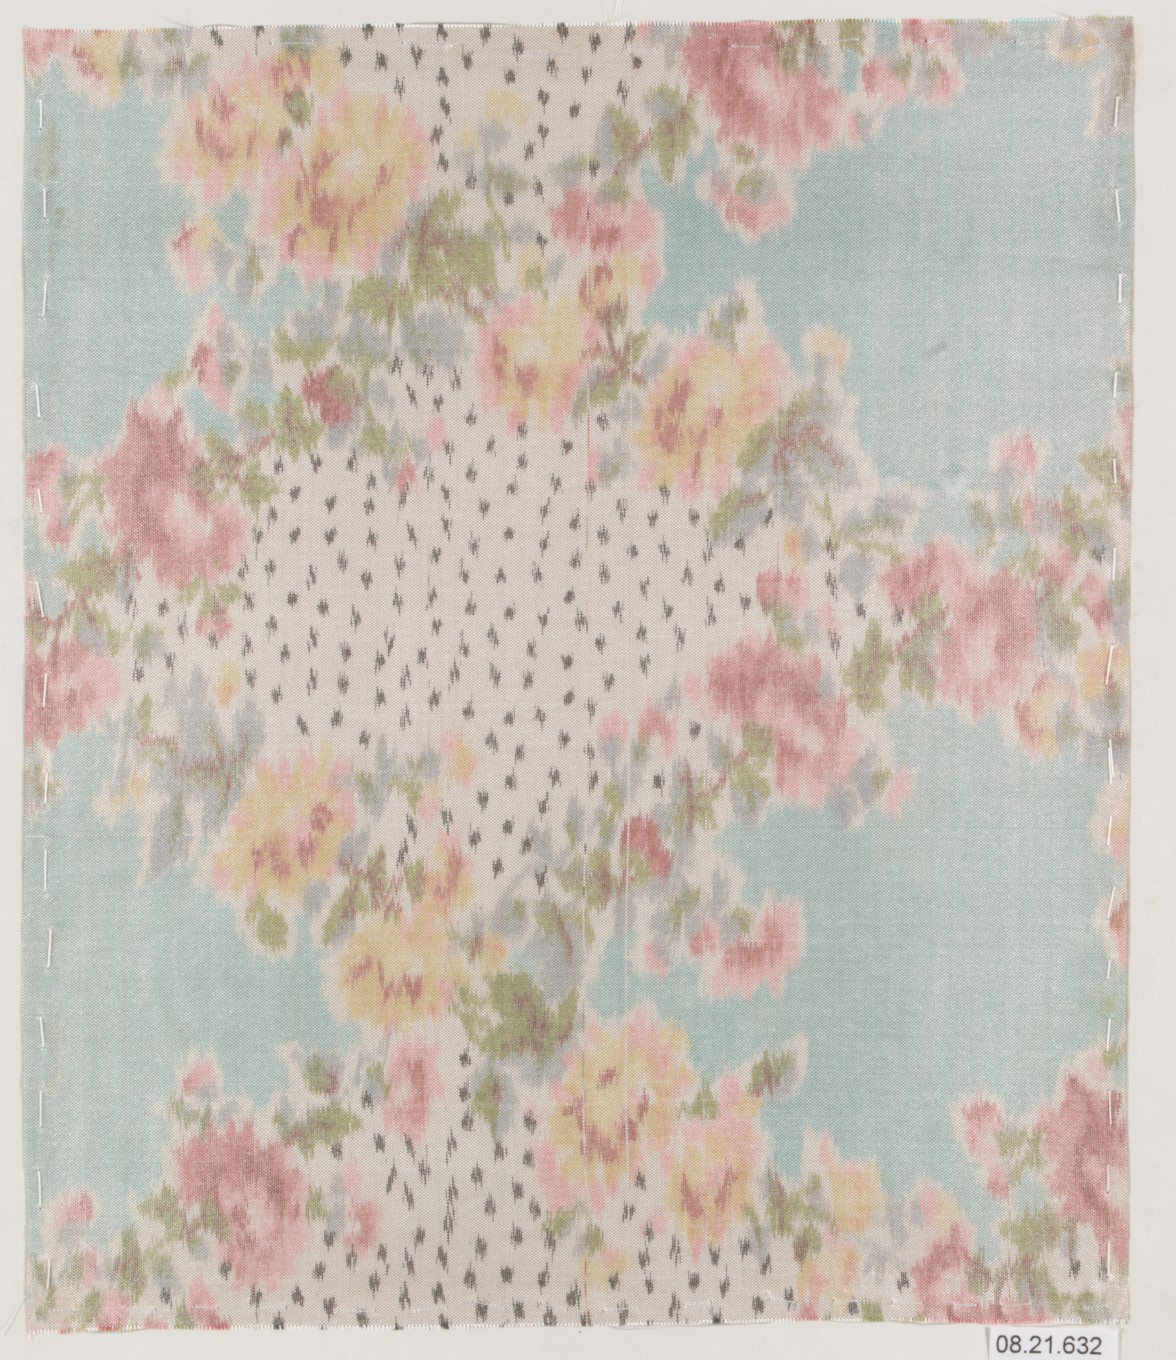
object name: textile sample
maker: Anonymous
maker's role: designer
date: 1900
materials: silk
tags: flowers